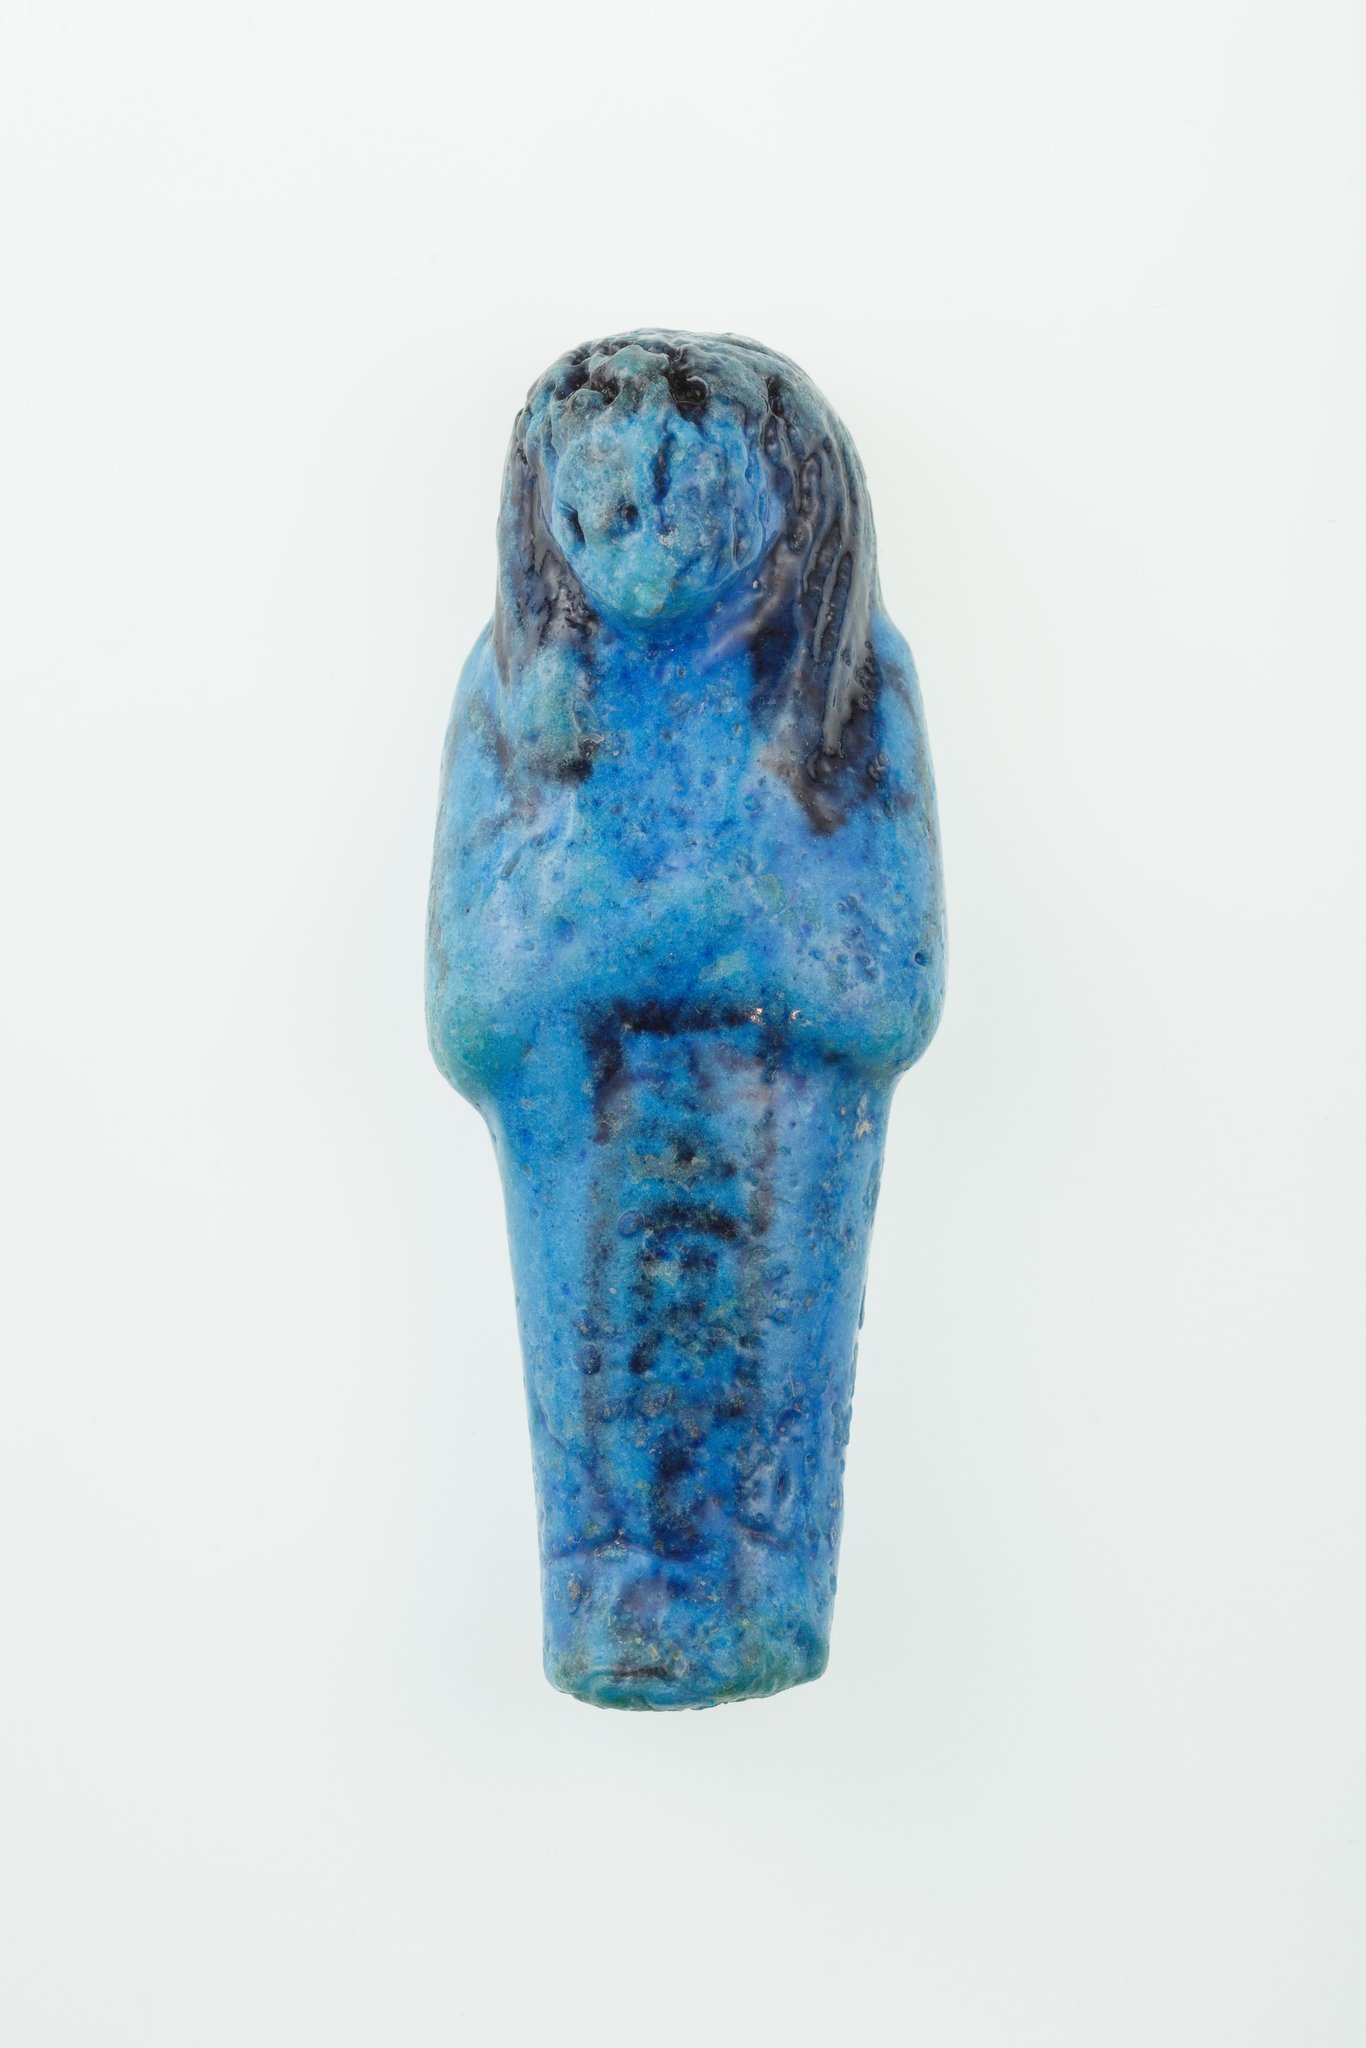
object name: shabti, worker, nauny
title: Worker Shabti of Nauny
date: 1050 BCE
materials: faience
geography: egypt